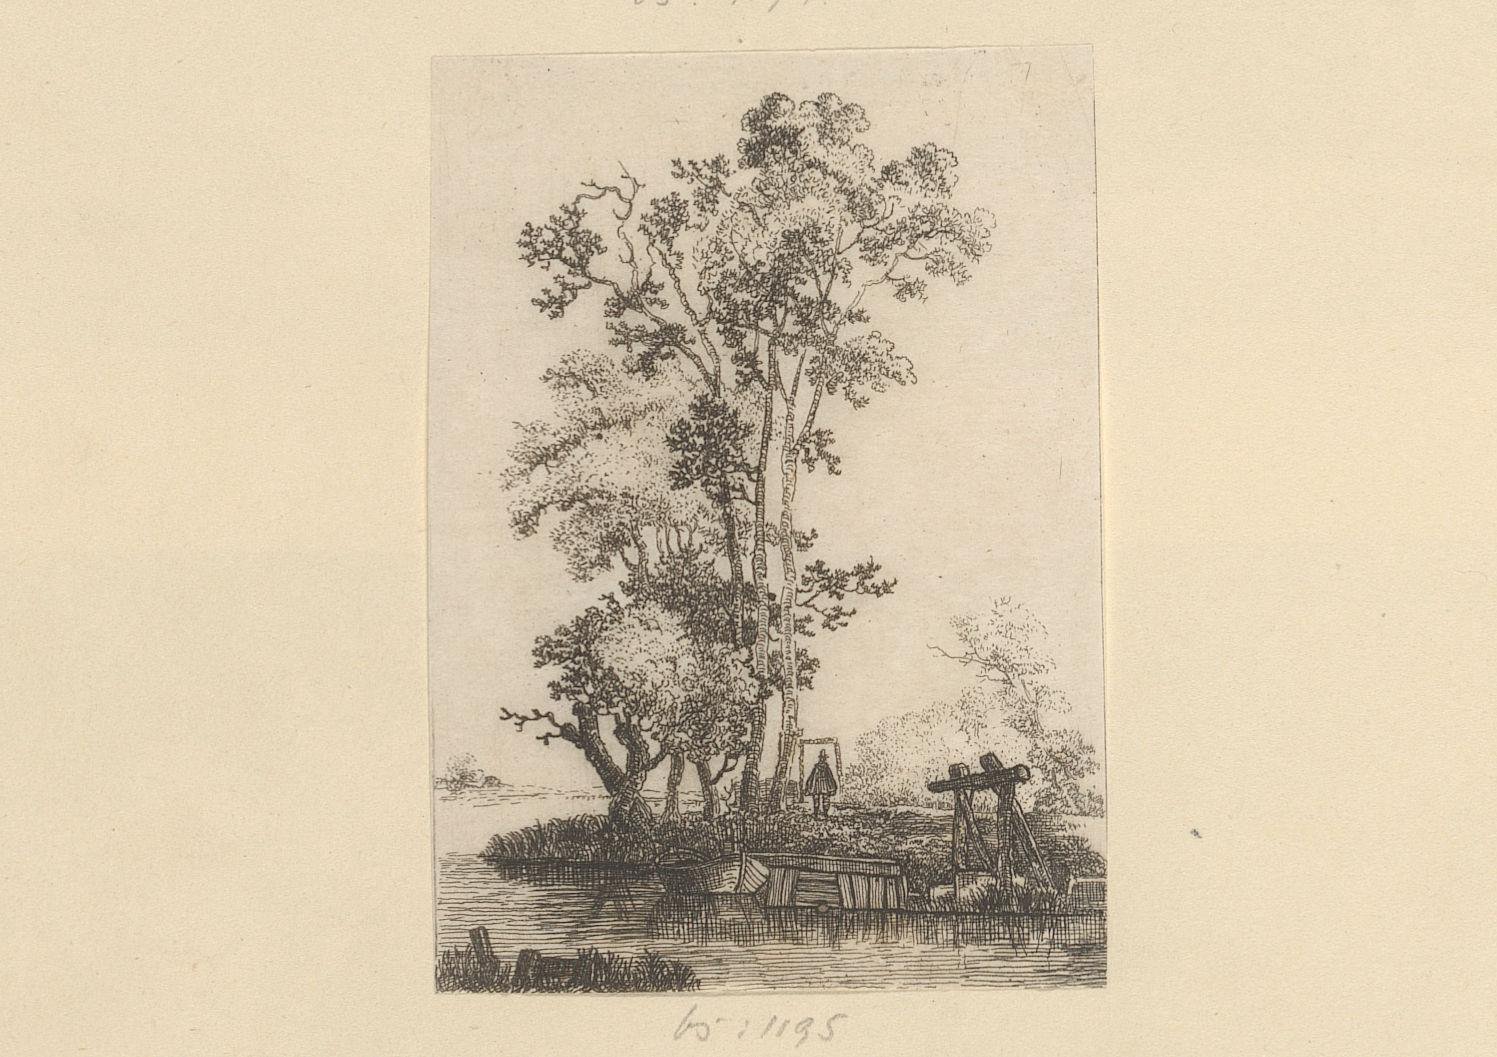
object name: album leaf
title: Twenty rural landscapes from nature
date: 1793-1795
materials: paper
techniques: etching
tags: bank, landscapes (+ landscape with figures, staffage), farm (building)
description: Deze prent hoort bij een serie van 20 prenten. Prent maakt mogelijk deel uit van een serie van 200 prenten. Deze serie is onder de titel 'A Collection of two hundred original etchings' voor het eerst uitgegeven door J.M. Greery in 1816.